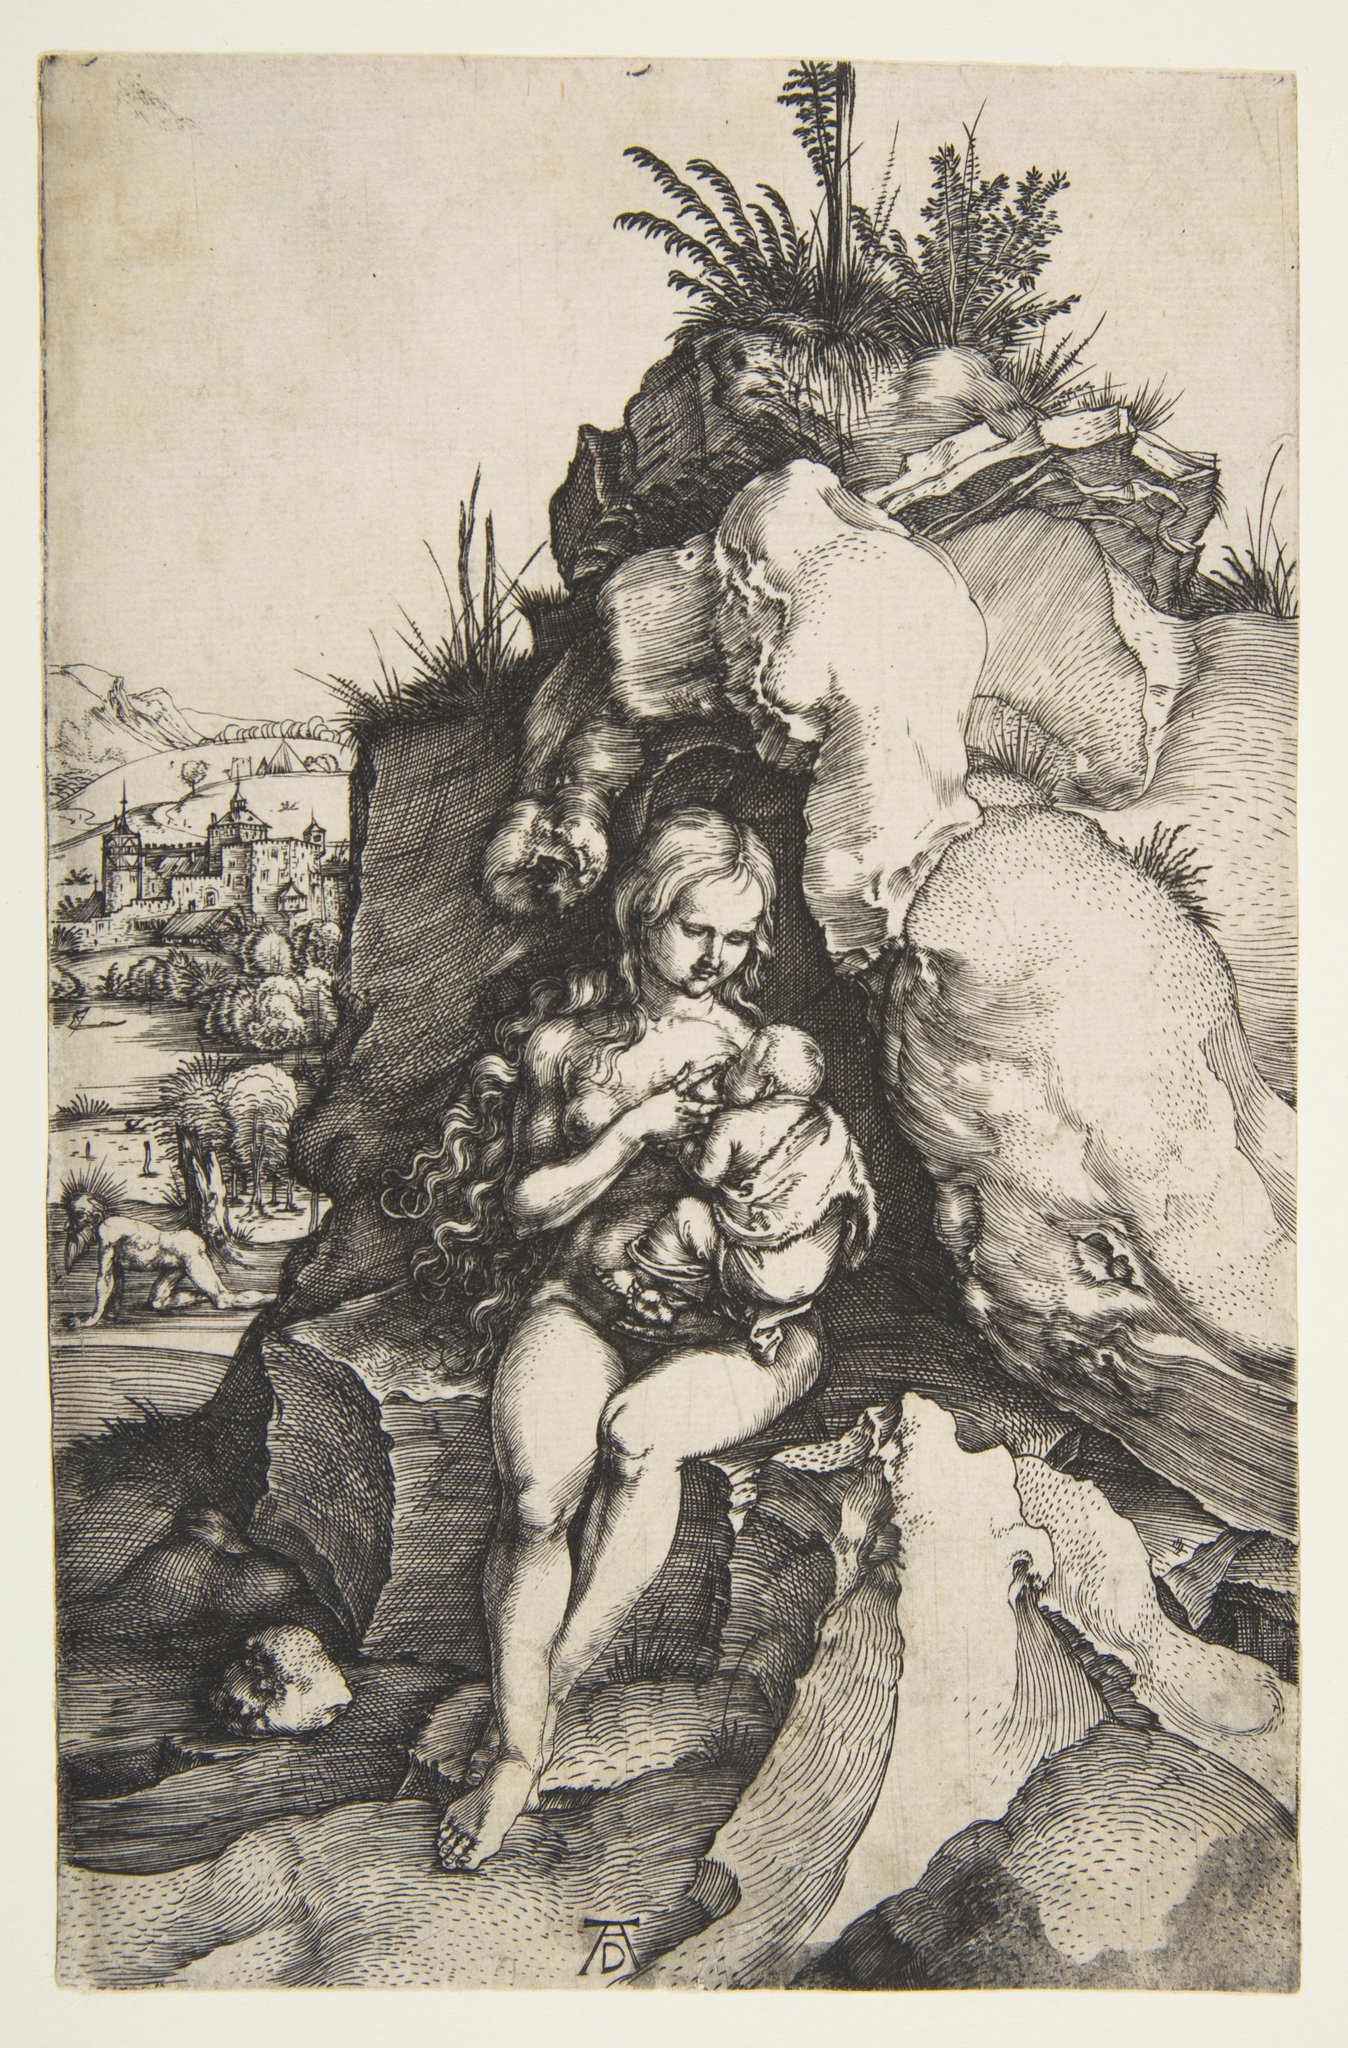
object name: print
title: The Penance of Saint John Chrysostom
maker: albrecht dürer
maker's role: artist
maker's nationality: german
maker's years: 1471-1528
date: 1496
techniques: engraving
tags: madonna and child